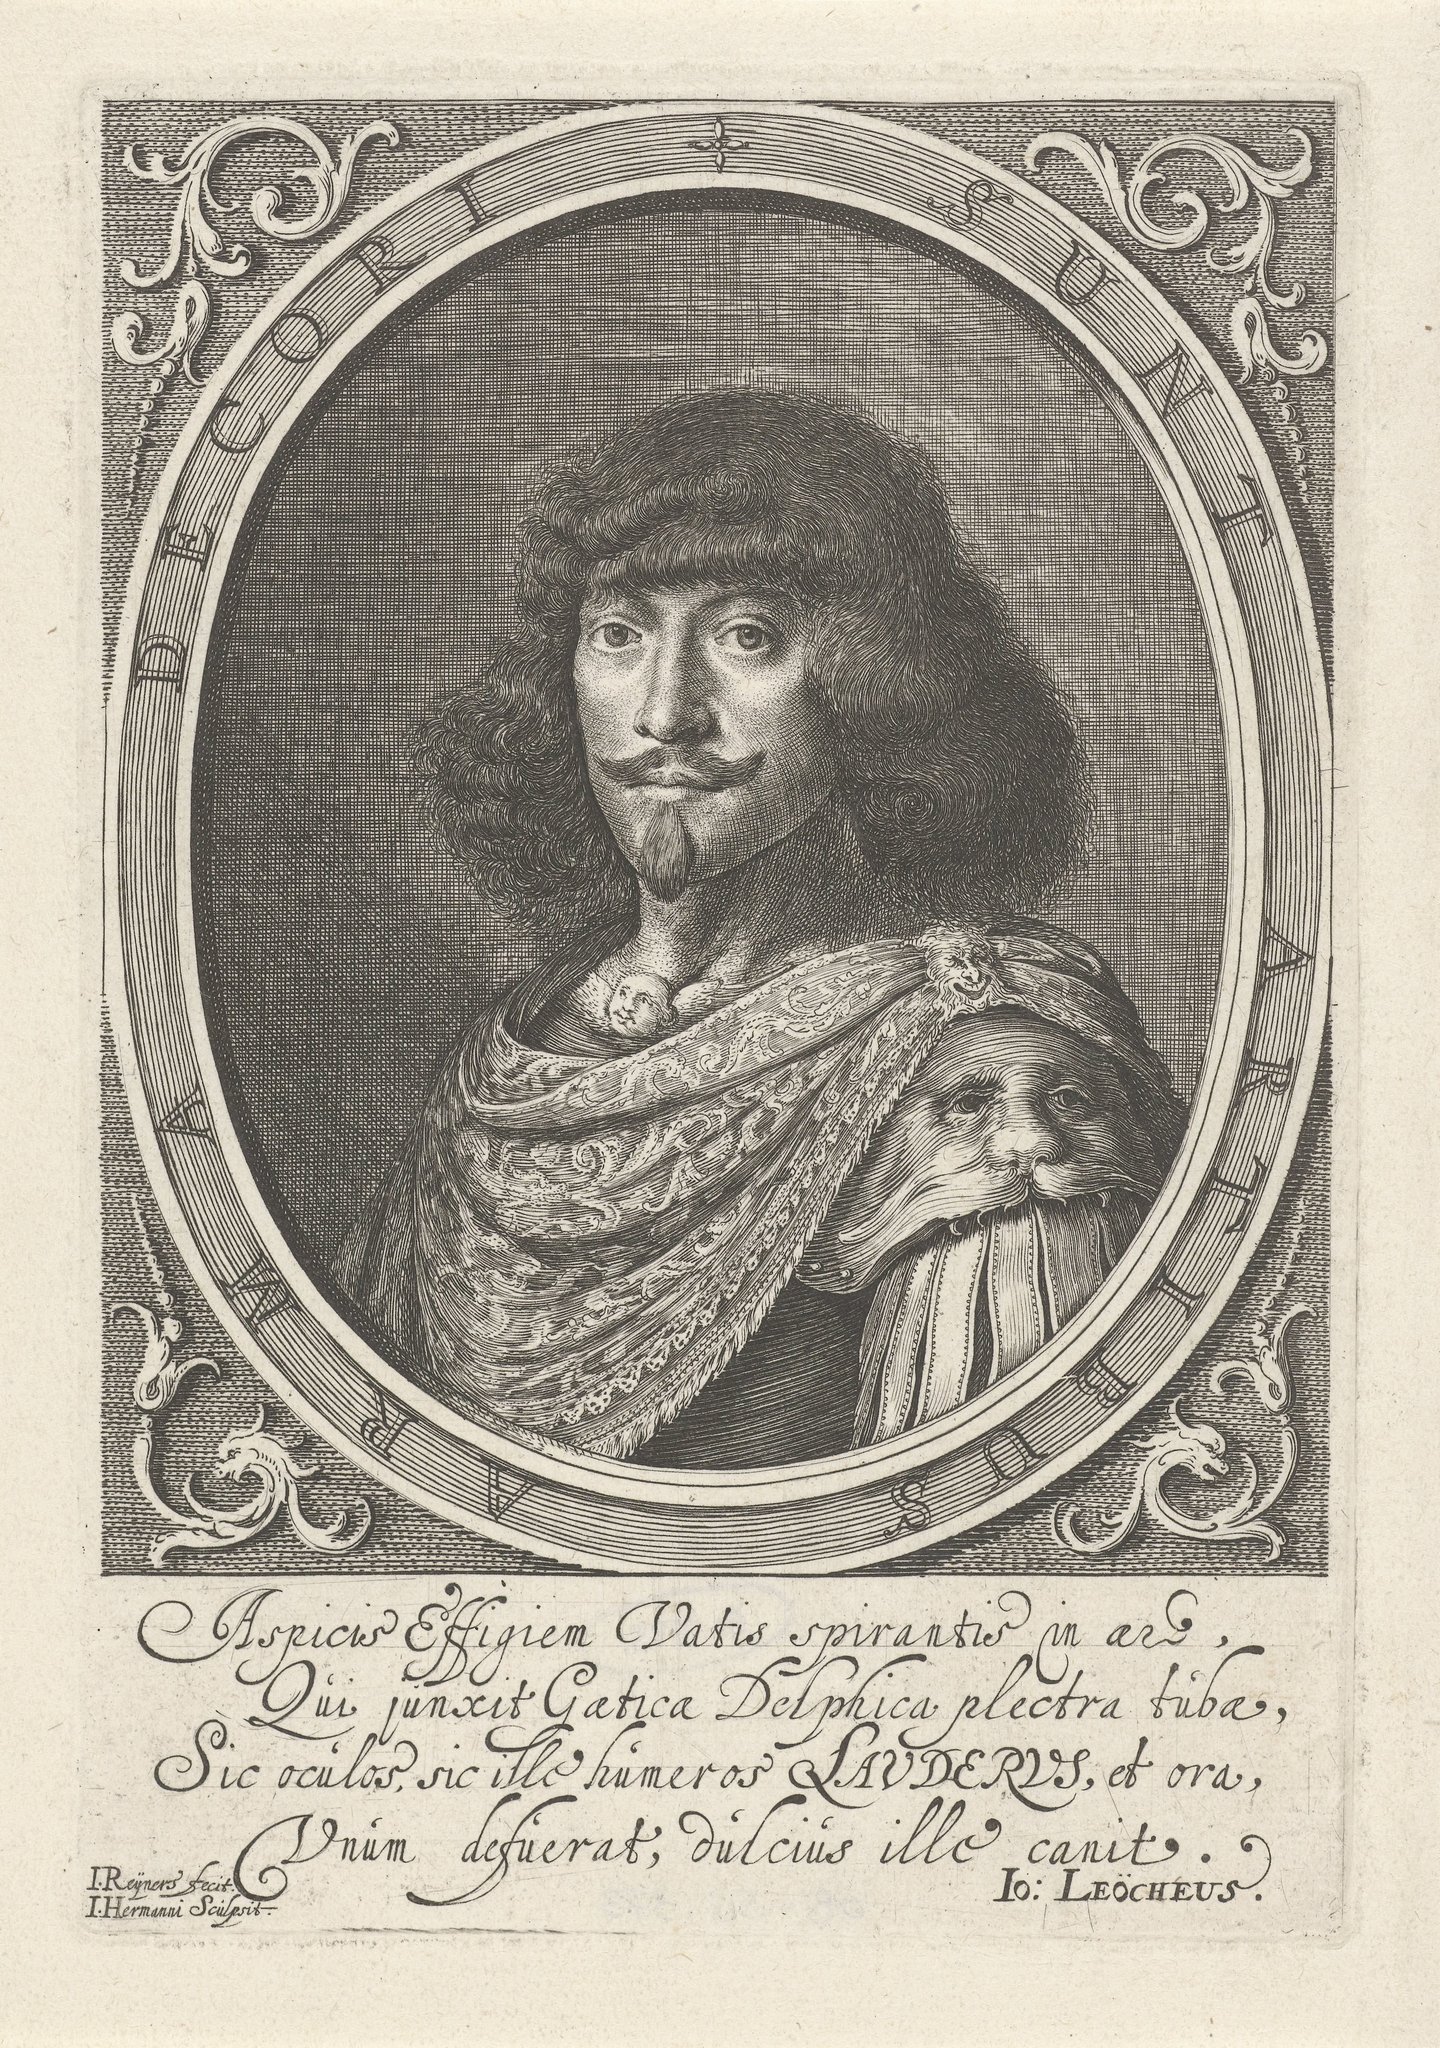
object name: print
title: Portret van de dichter Lauderus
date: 1600-1650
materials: paper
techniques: engraving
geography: leeuwarden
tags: moustache, beard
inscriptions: collector's mark: Lugt 2228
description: Buste naar links van de dichter Lauderus in een ovaal. Onder het portret een vierregelige tekst in het Latijn.